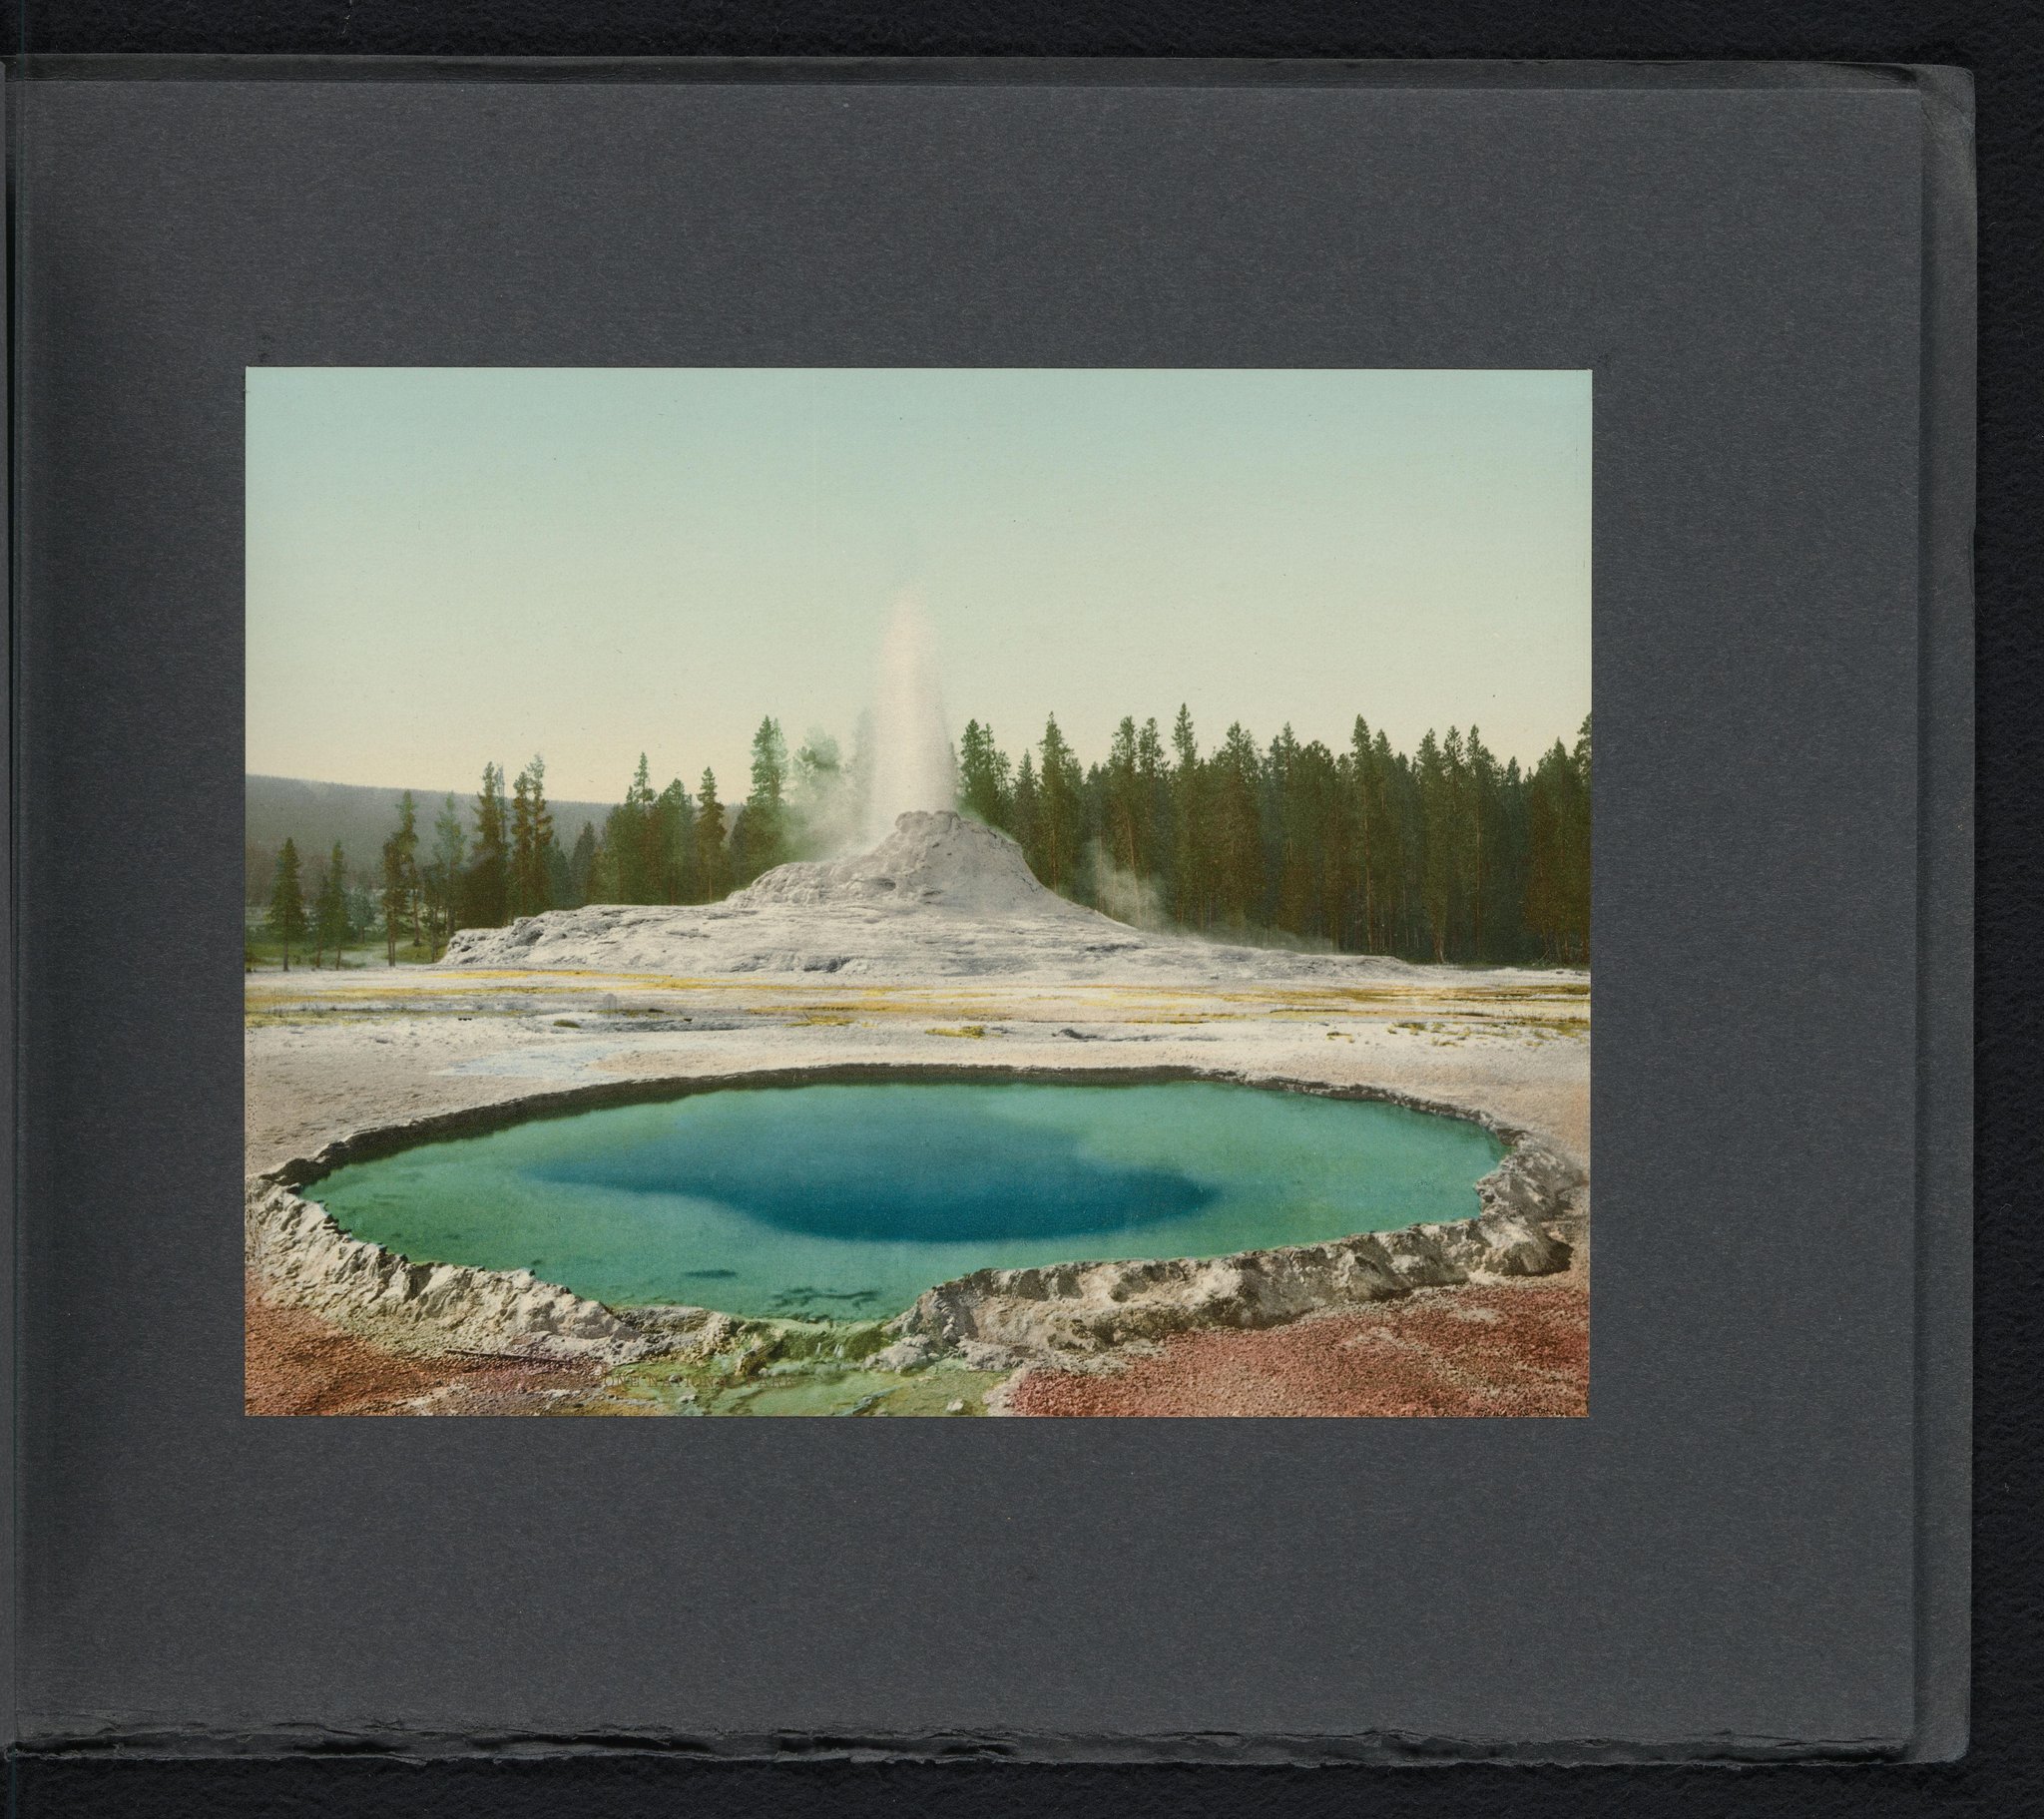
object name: page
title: Castle Geyser, Yellowstone National Park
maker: william henry jackson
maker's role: fotograaf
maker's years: 1843-1942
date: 1889-1902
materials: paper, photographic process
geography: yellowstone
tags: steam, hot spring, geyser, trees: pine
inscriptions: inscription: ‘53313/ COPYRIGHT, 1899, BY/ DETROIT PHOTOGRAPHIC CO.’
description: Prent op eenentwintigste ongenummerde pagina.